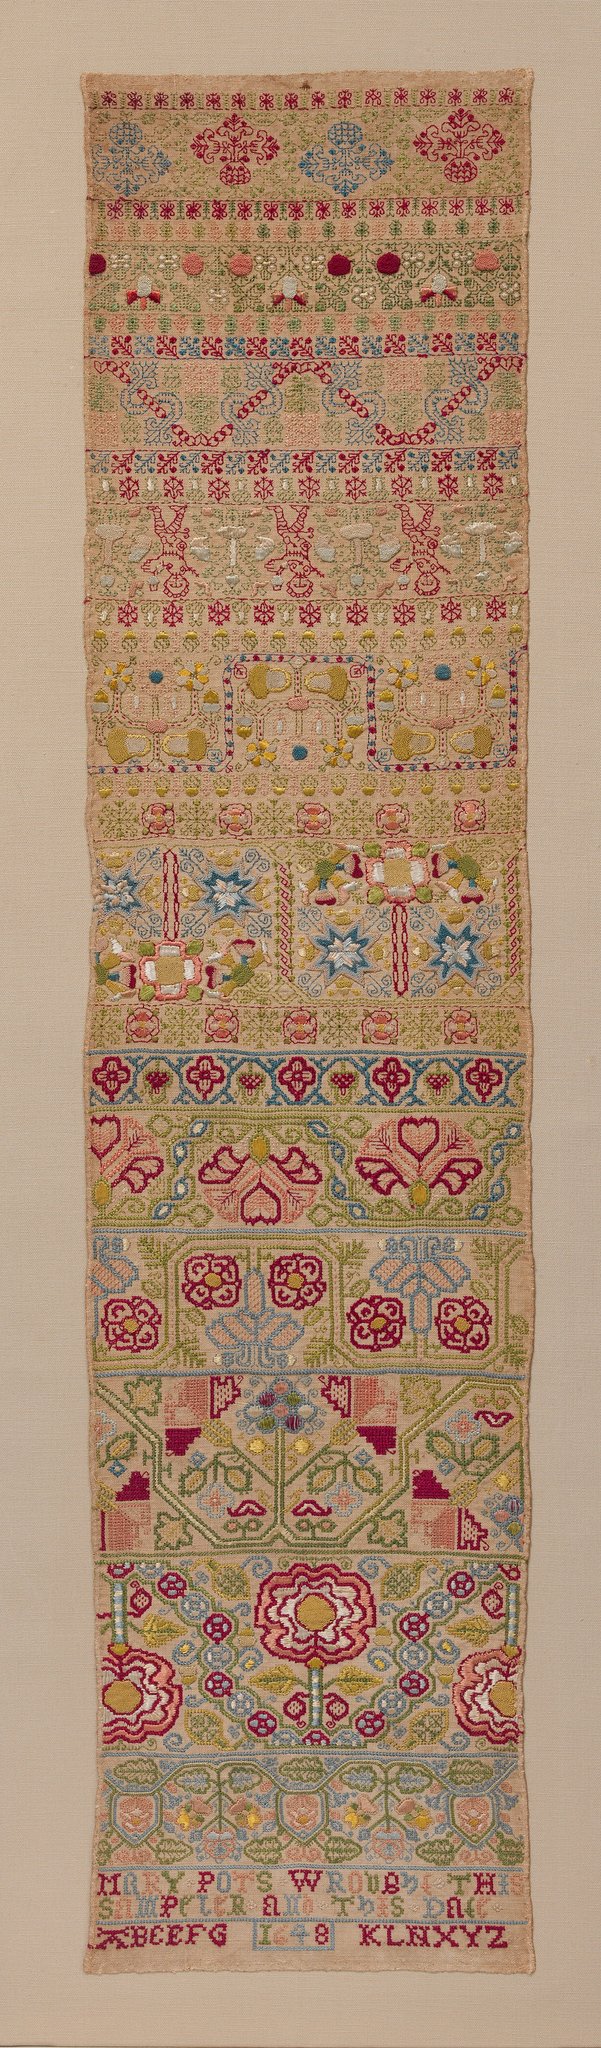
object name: sampler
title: Embroidered band sampler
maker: mary pots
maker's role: maker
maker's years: 1600-1700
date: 1648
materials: linen, textile, silk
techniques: embroidery, stitching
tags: flowers